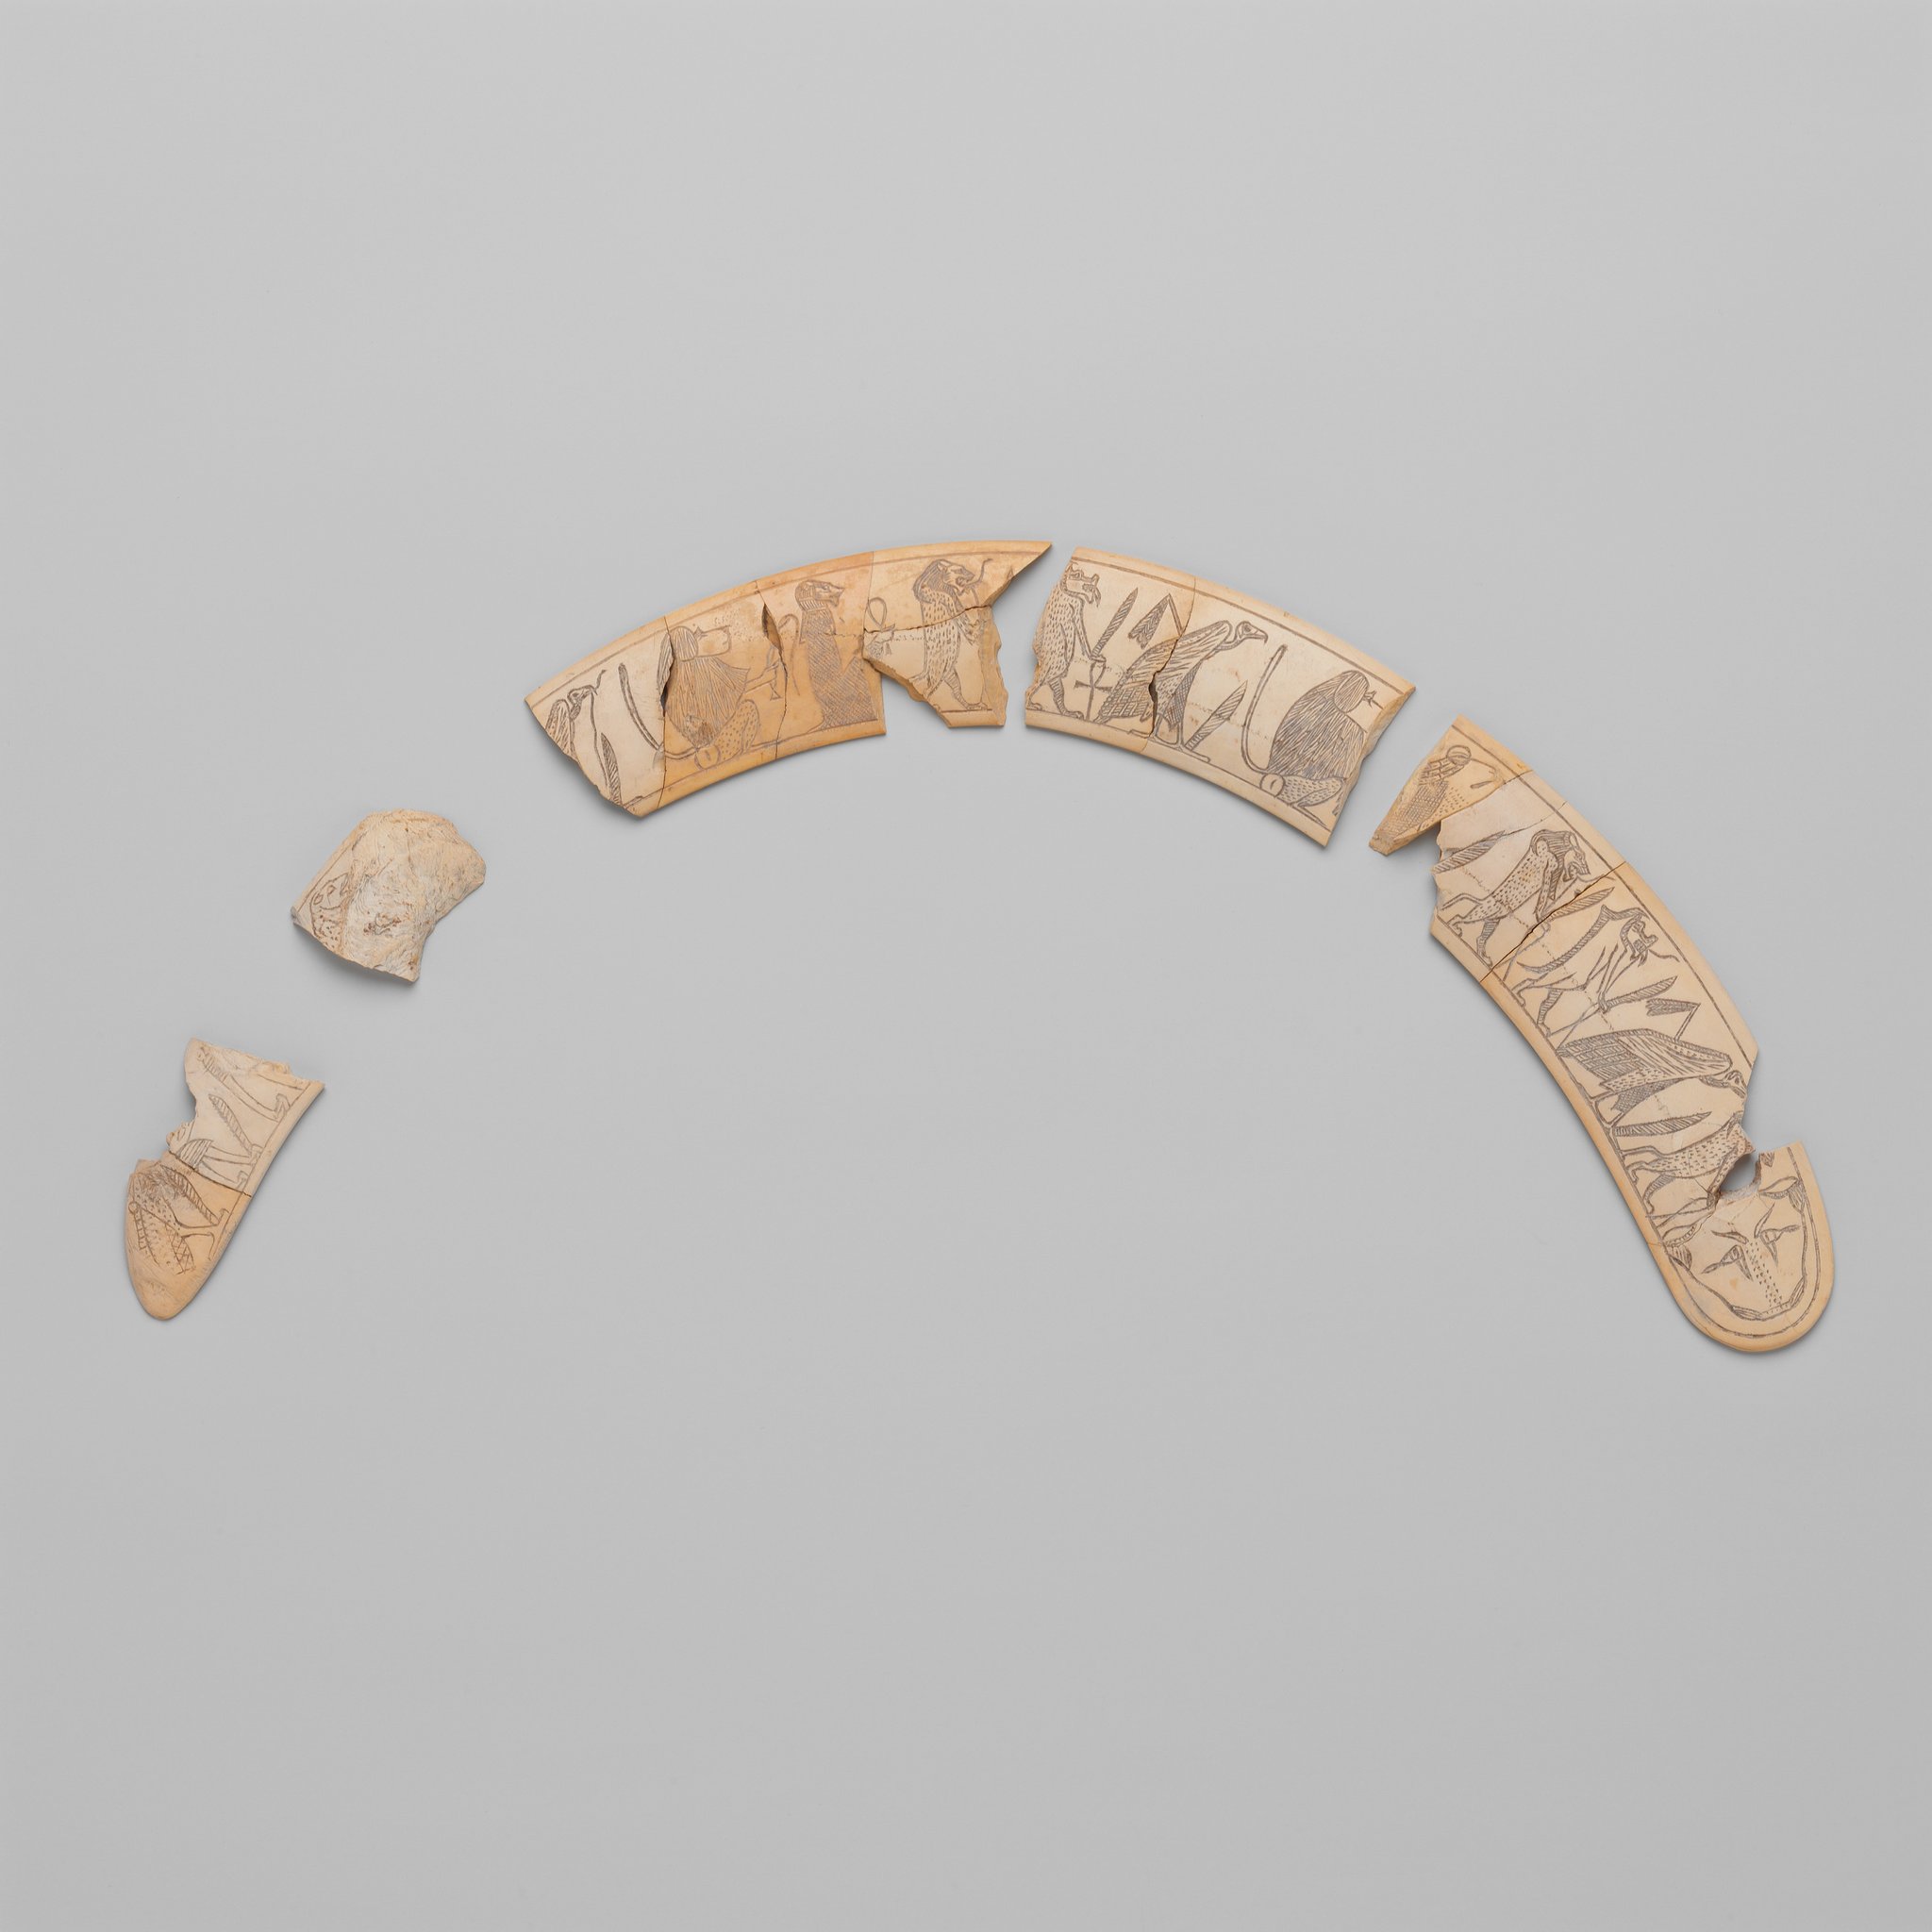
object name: magic wand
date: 1981-1802 BCE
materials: ivory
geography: egypt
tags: birds,lions